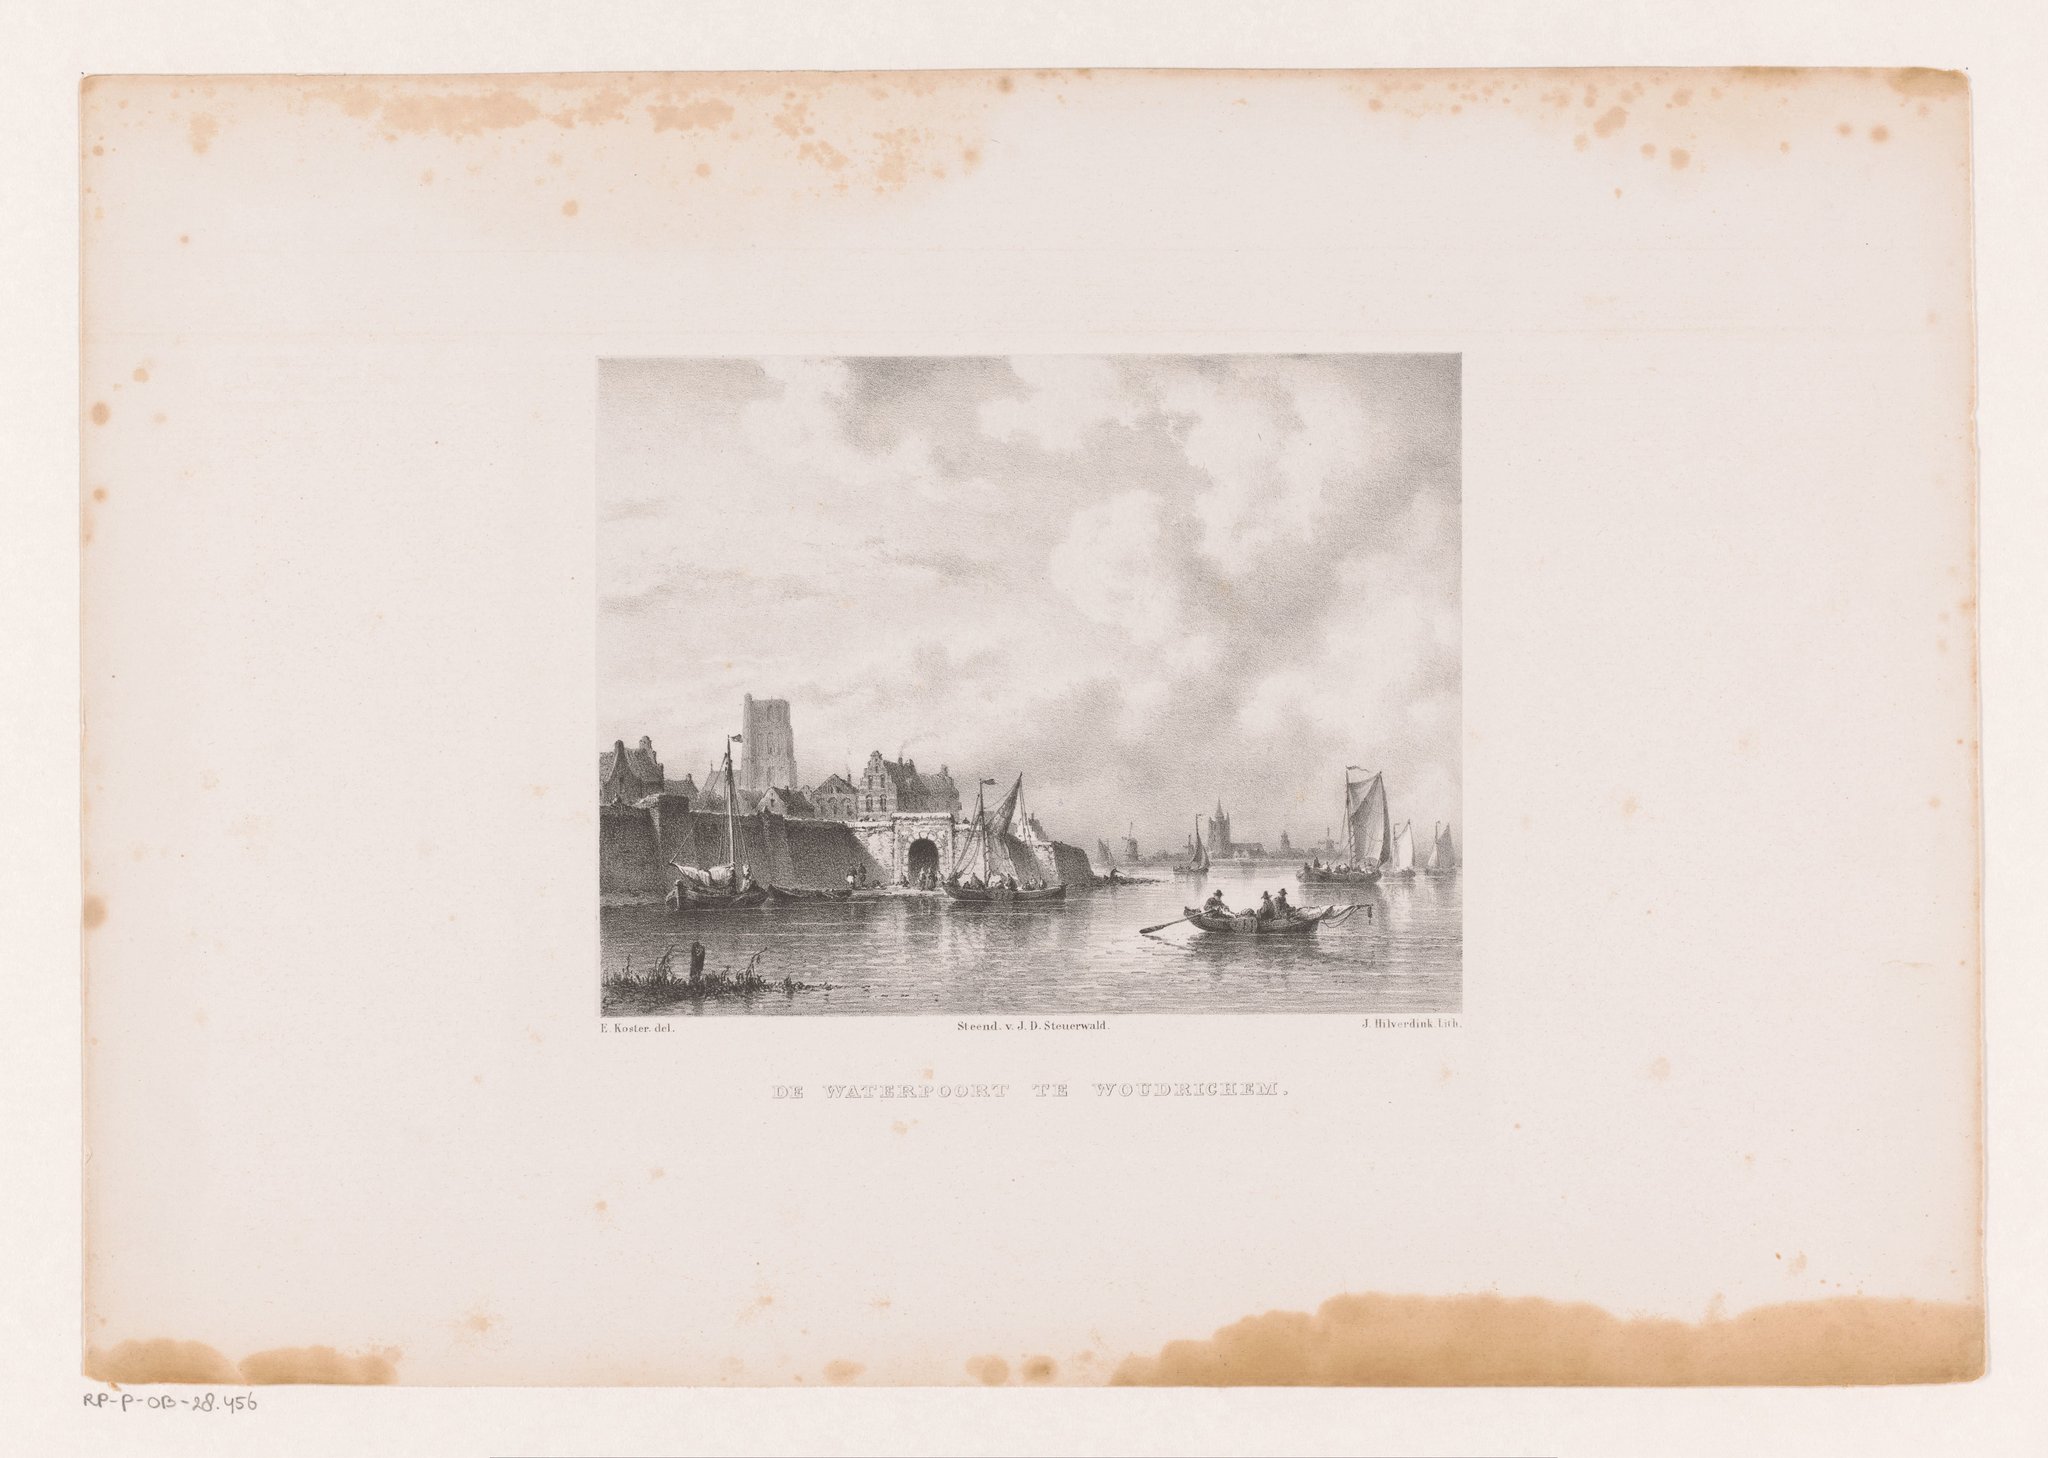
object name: print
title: Waterpoort in Woudrichem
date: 1858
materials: paper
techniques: lithograph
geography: amsterdam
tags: watergate, fortified city, woudrichem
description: Deze prent komt uit: Koster, E. 'E. Koster's schetsboek: Nederlandsche Stads- en Havengezichten, uitgegeven onder medewerking van de maatschappij Arti et Amicitiae, Amsterdam, F. Buffa en Zn., e.a.' Amsterdam 1858.